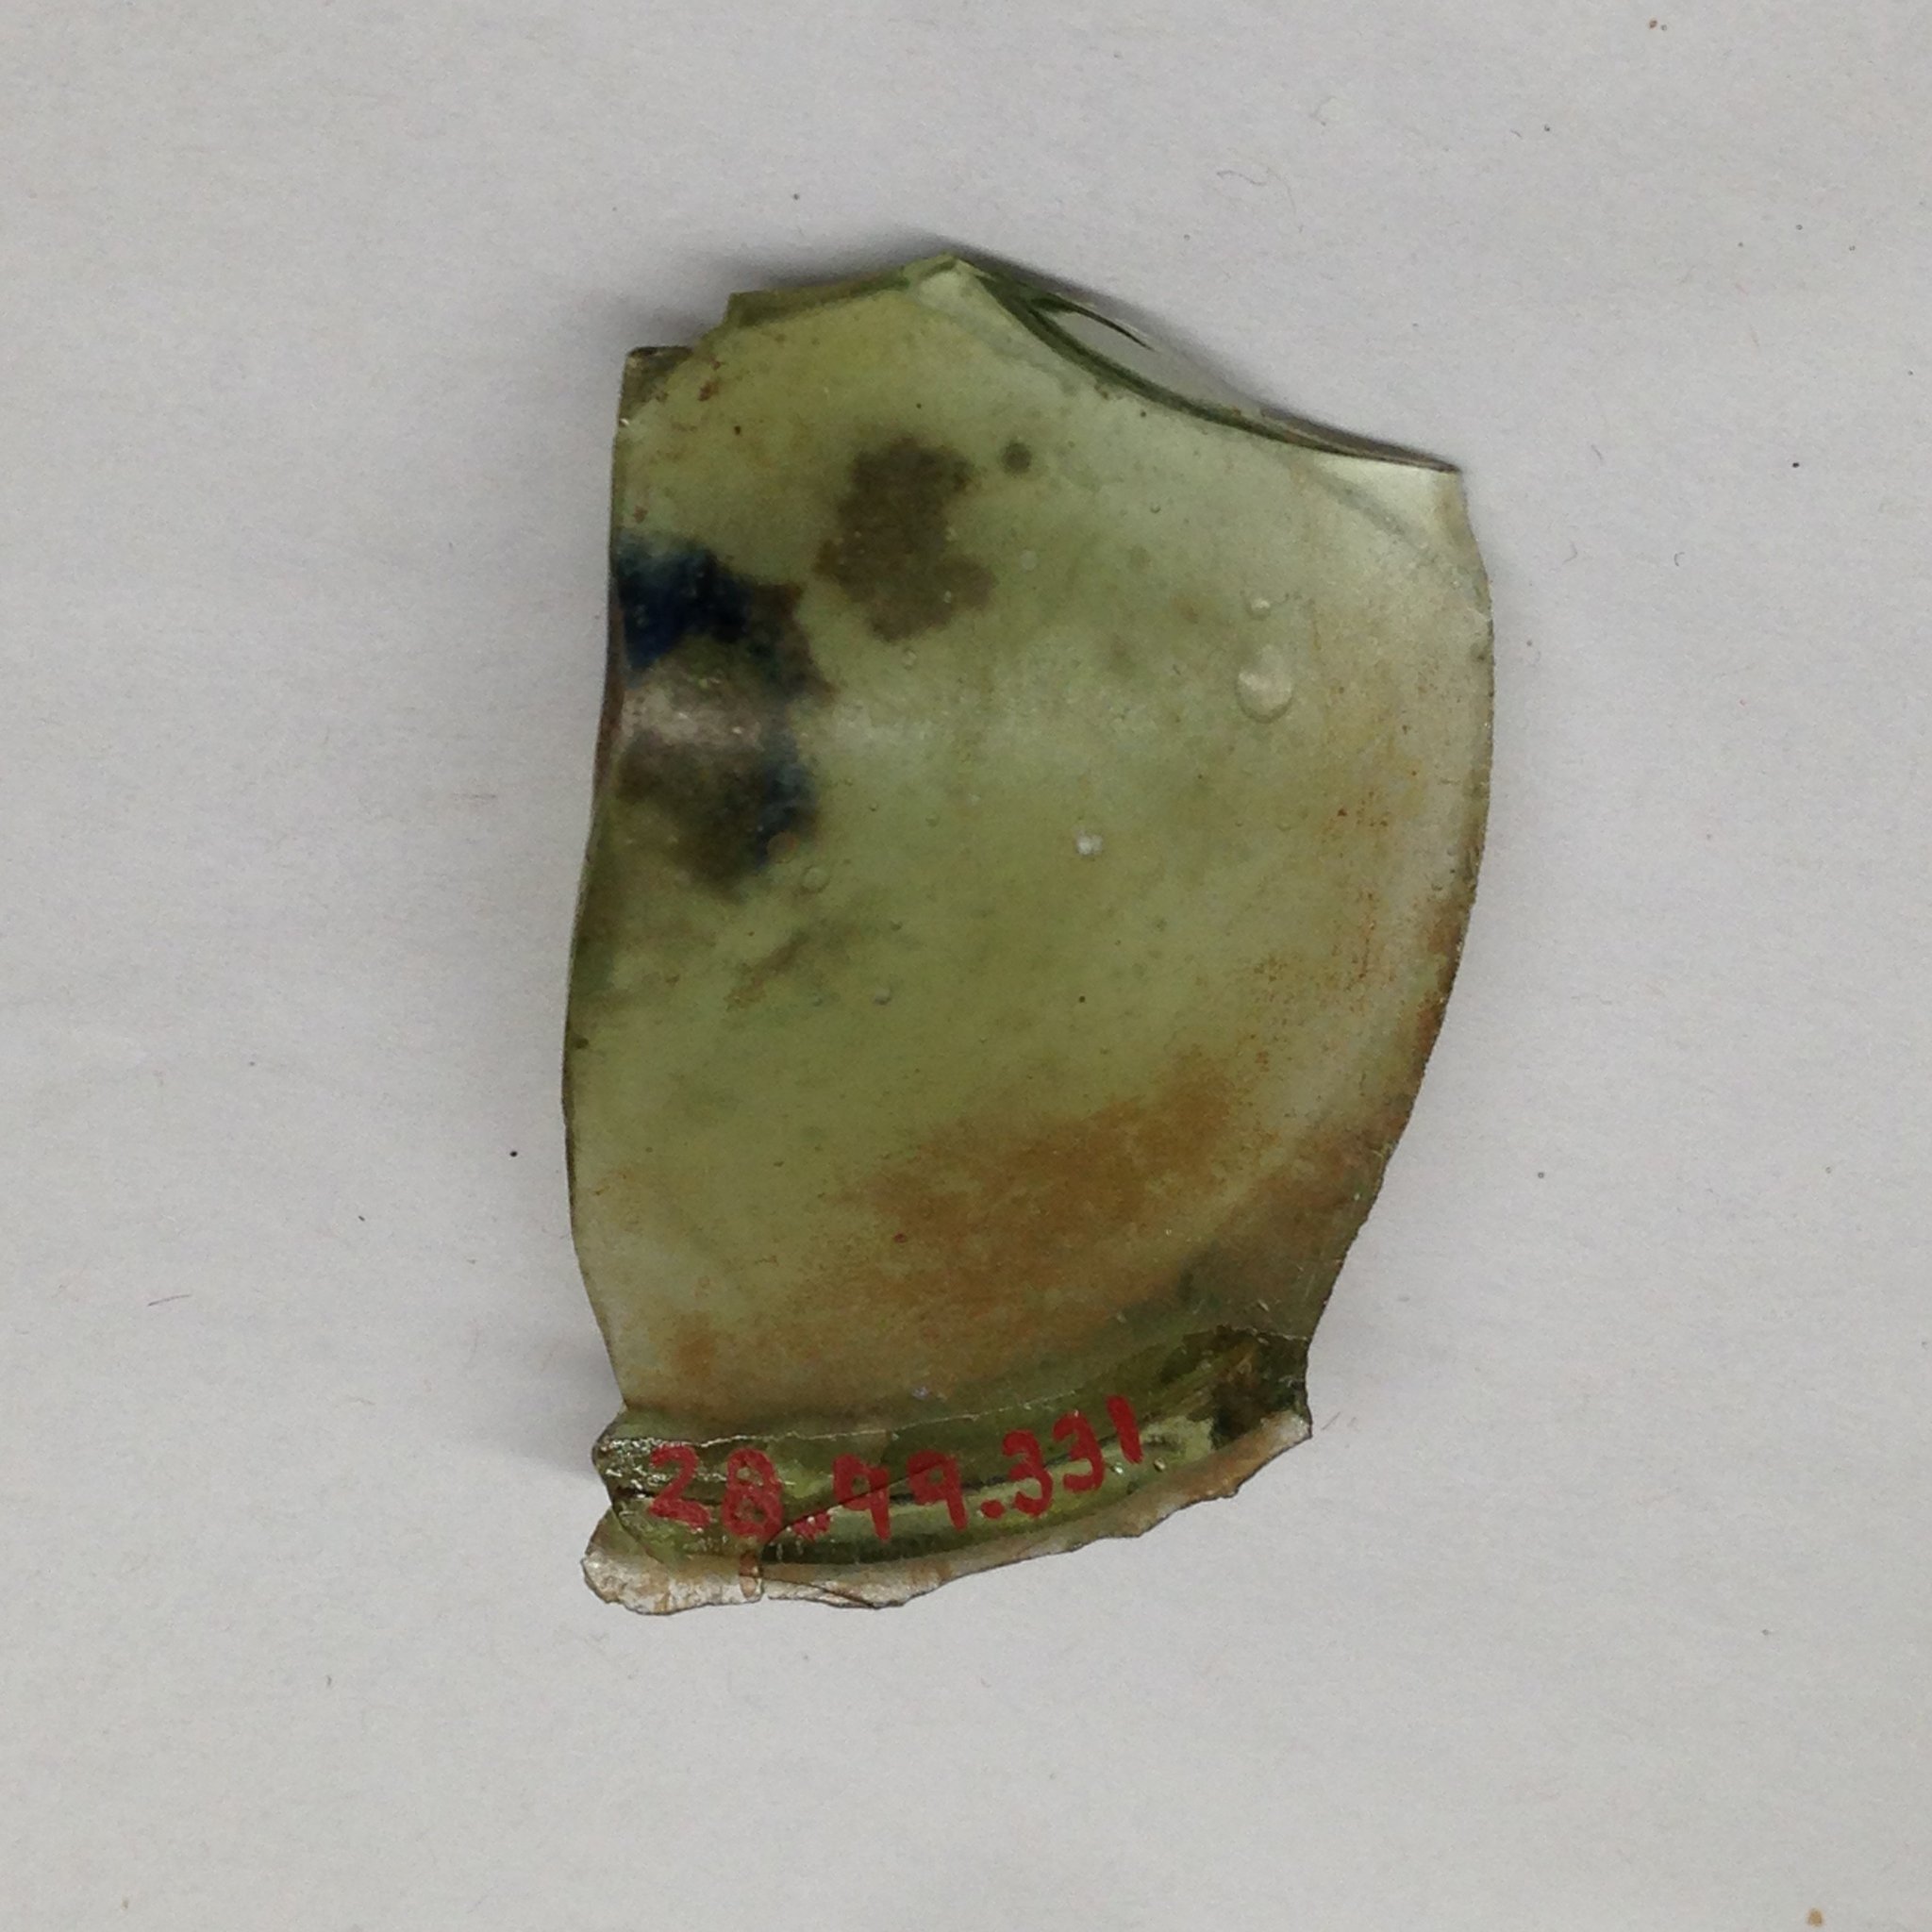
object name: fragment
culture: european or middle eastern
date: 1150-1250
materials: ceramic, glass